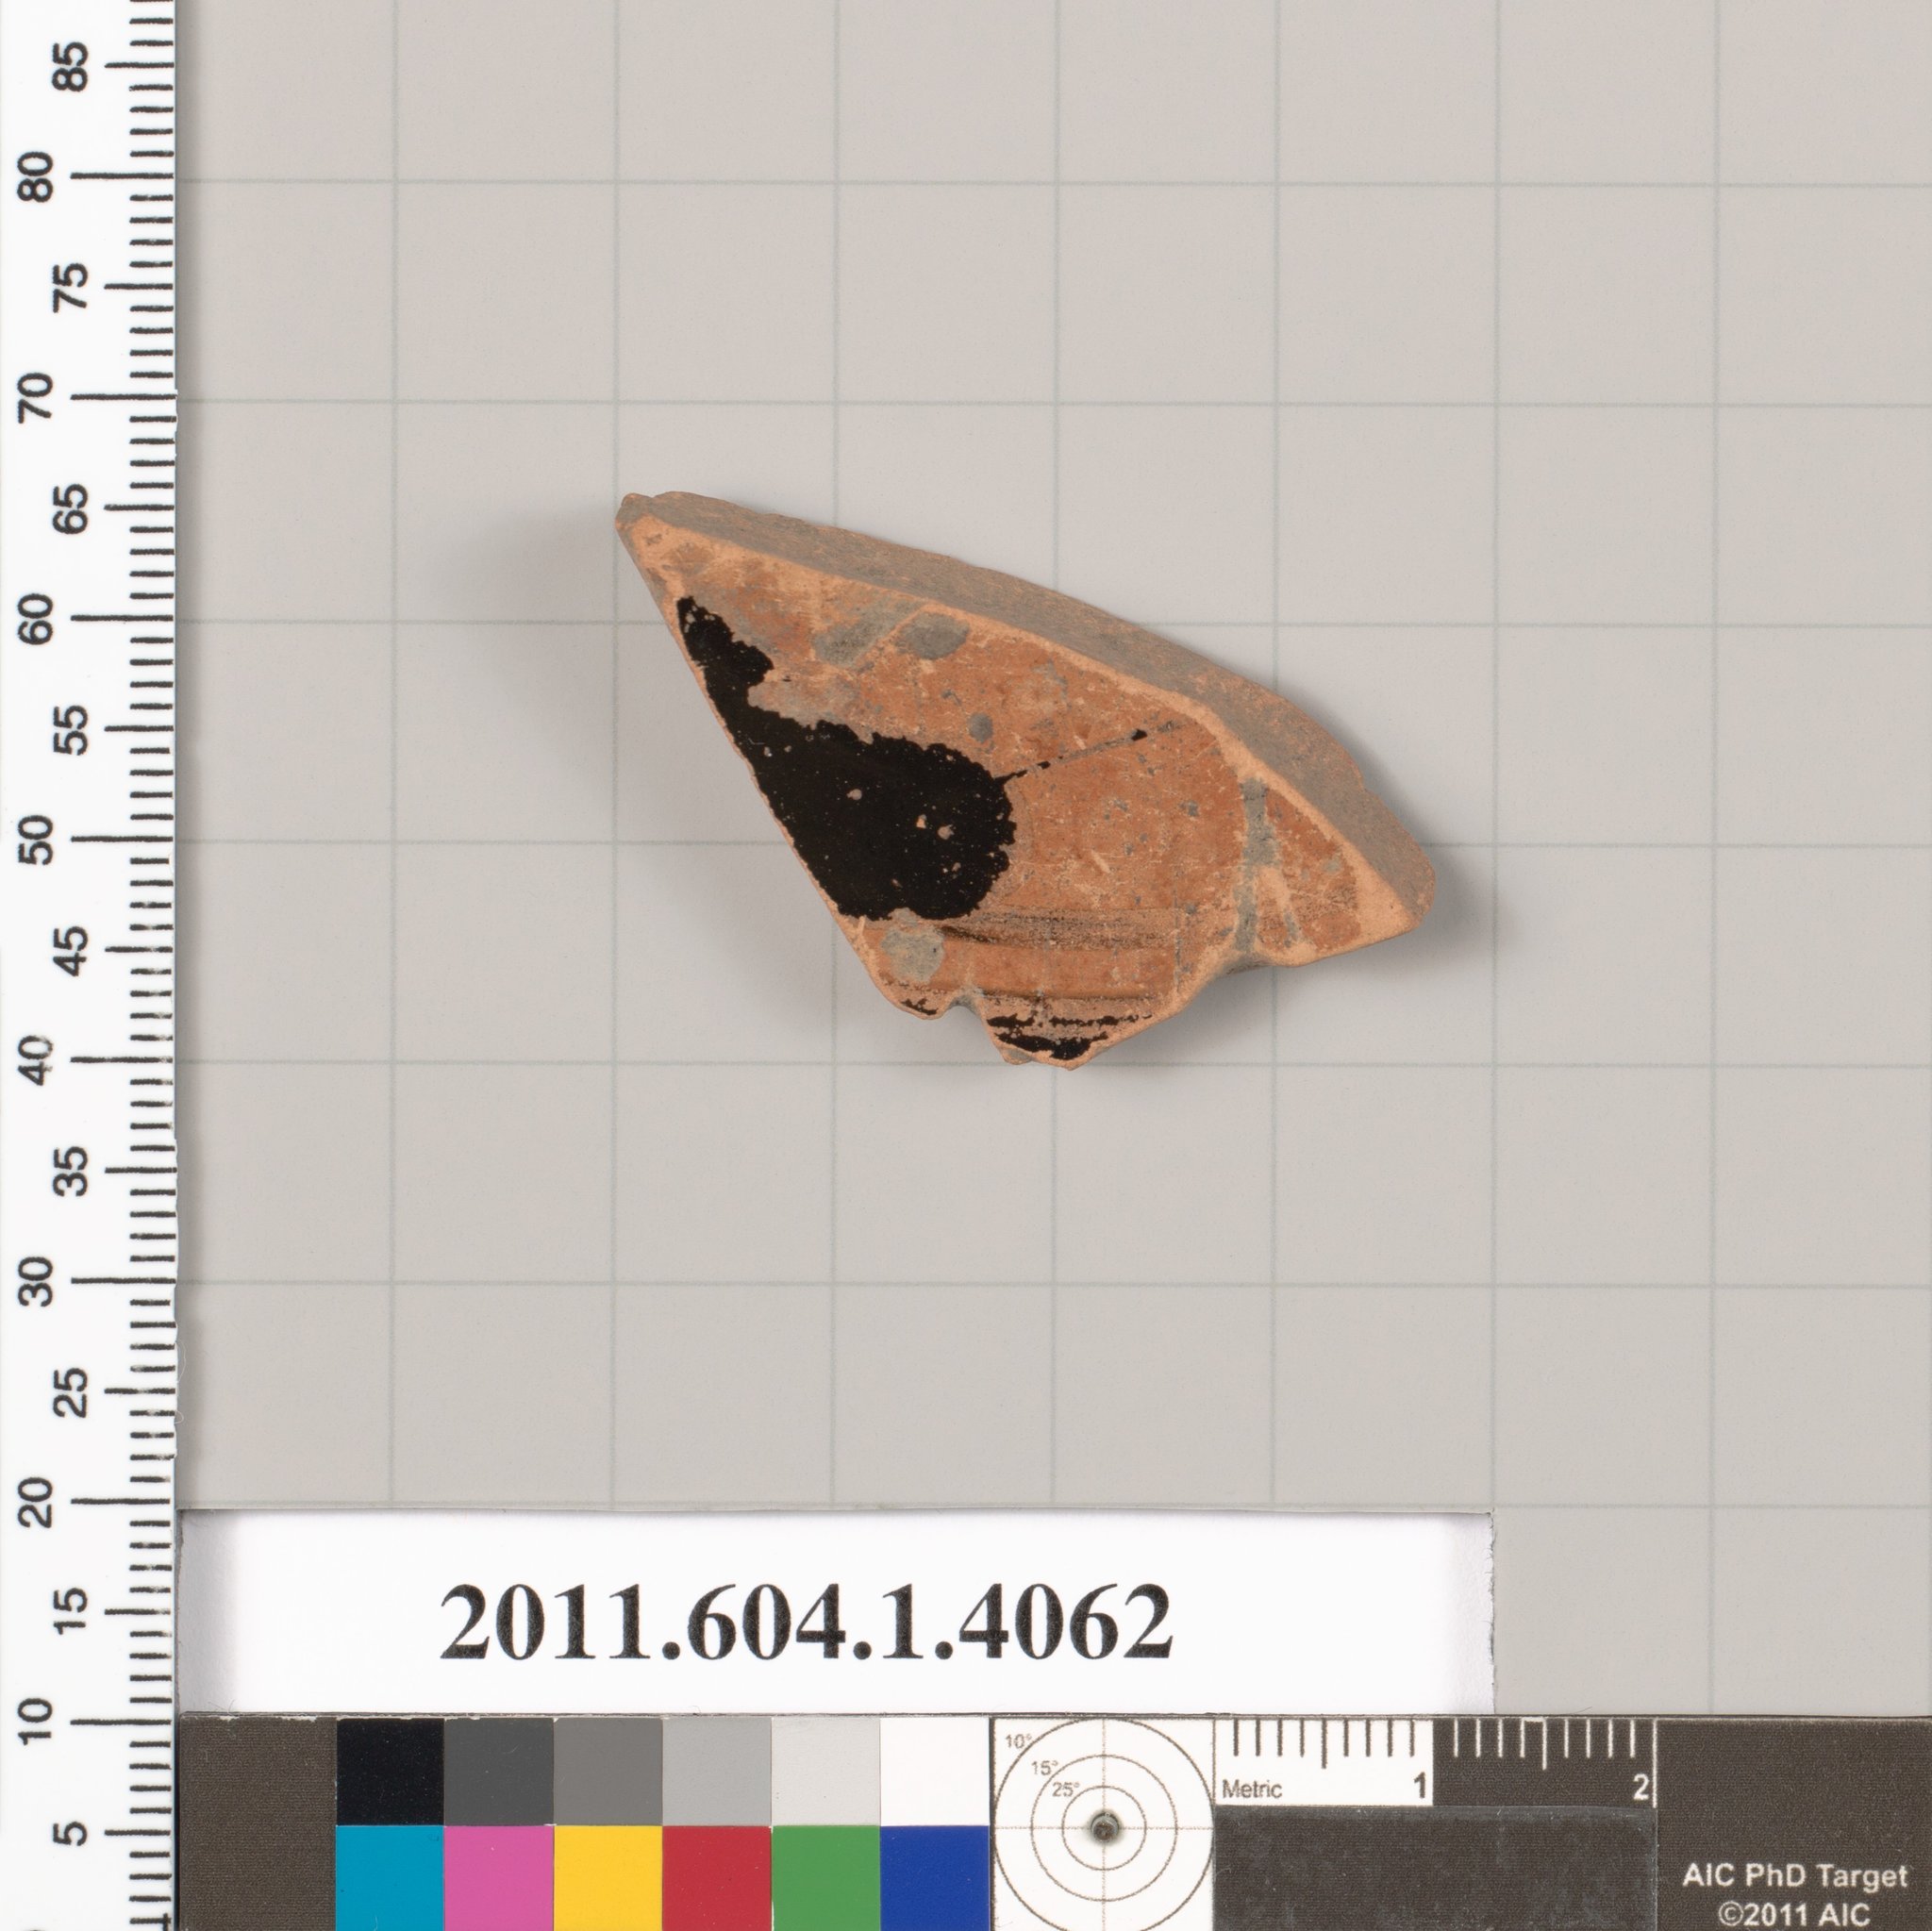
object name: kylix fragment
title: Terracotta fragment of a kylix (drinking cup)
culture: greek, attic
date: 500-451 BCE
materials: terracotta